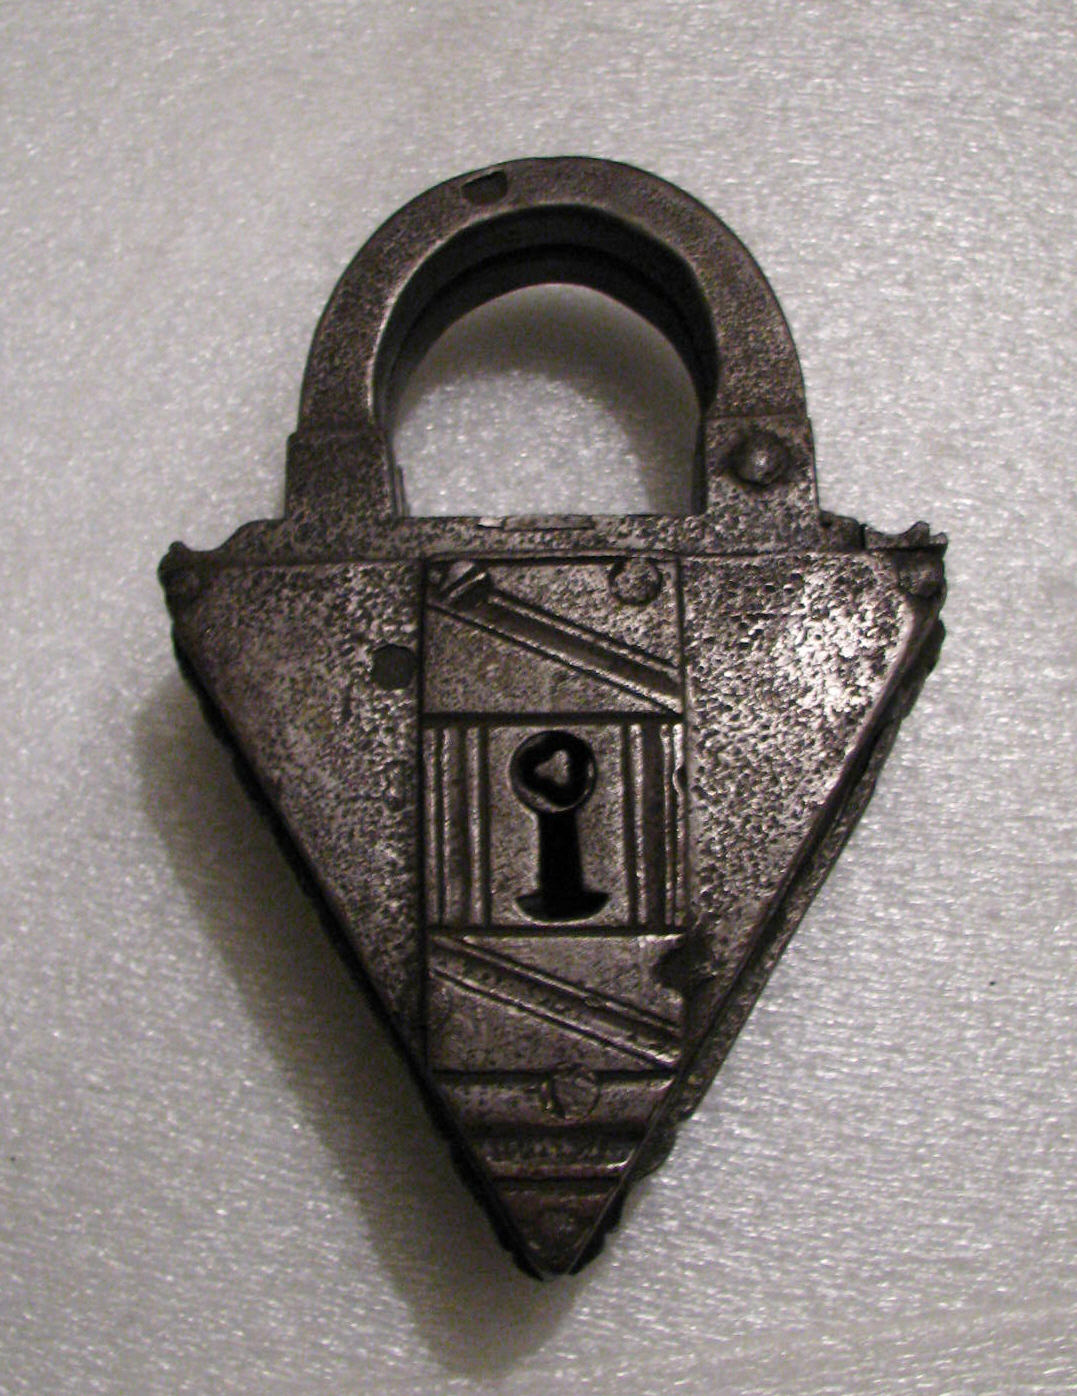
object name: padlock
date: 1601-1700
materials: iron